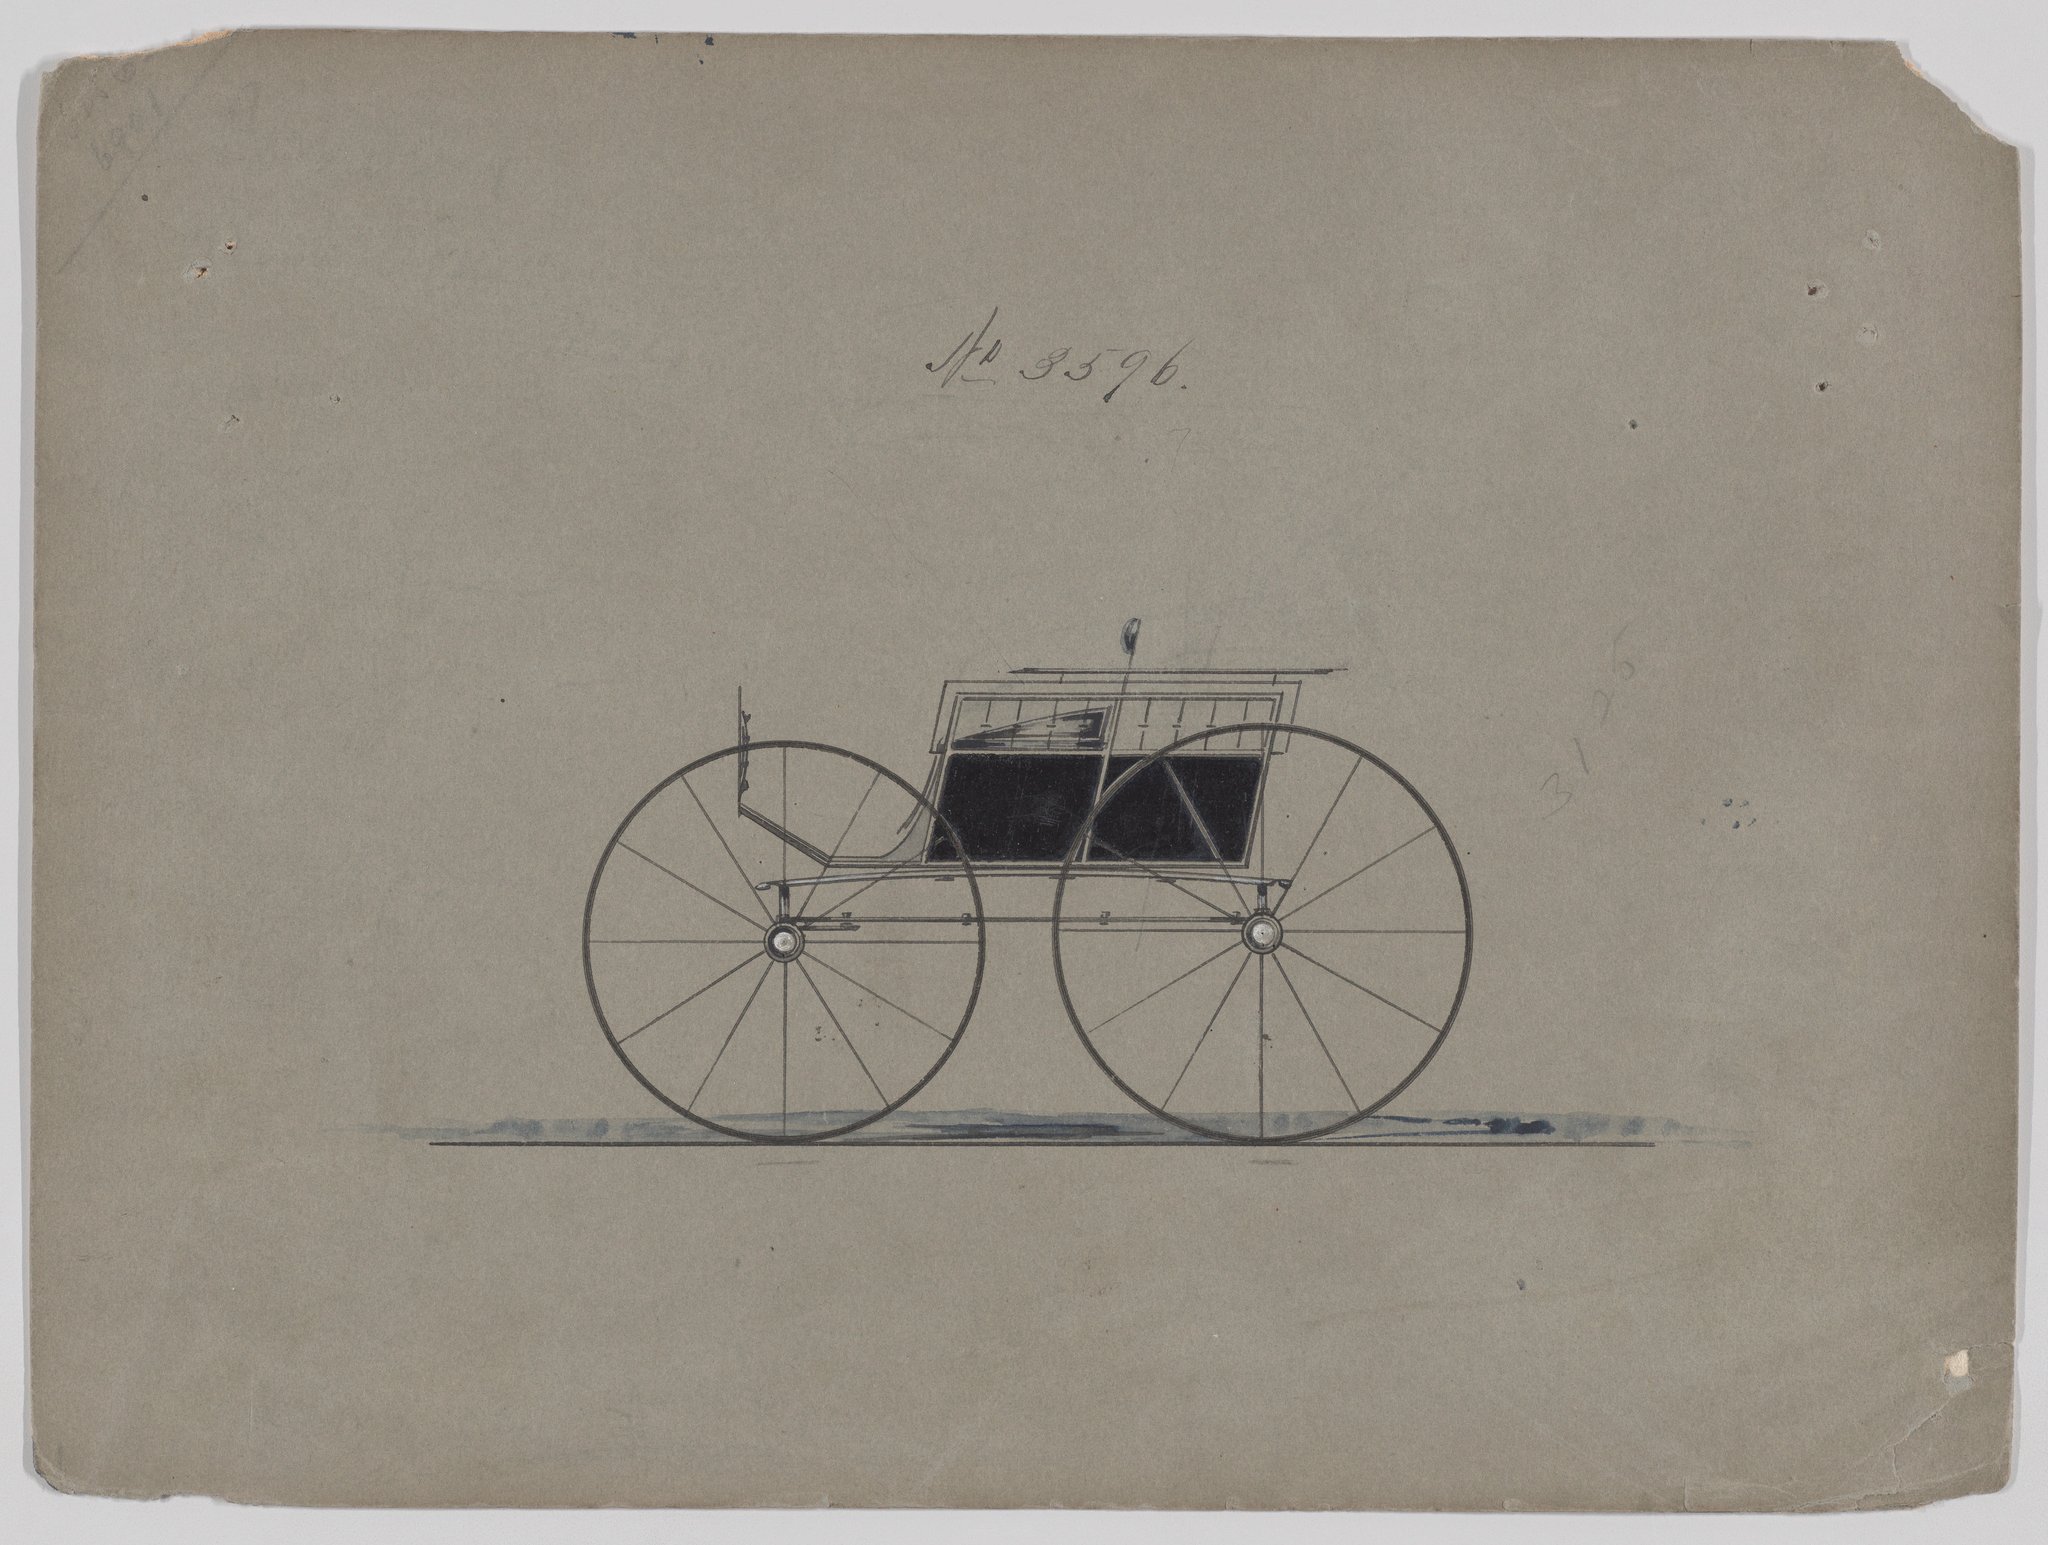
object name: drawing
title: Dos-a-Dos Phaeton #3596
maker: brewster & co.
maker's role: manufacturer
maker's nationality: american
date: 1880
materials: gouache, gum arabic, ink, watercolor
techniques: pen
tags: carriages